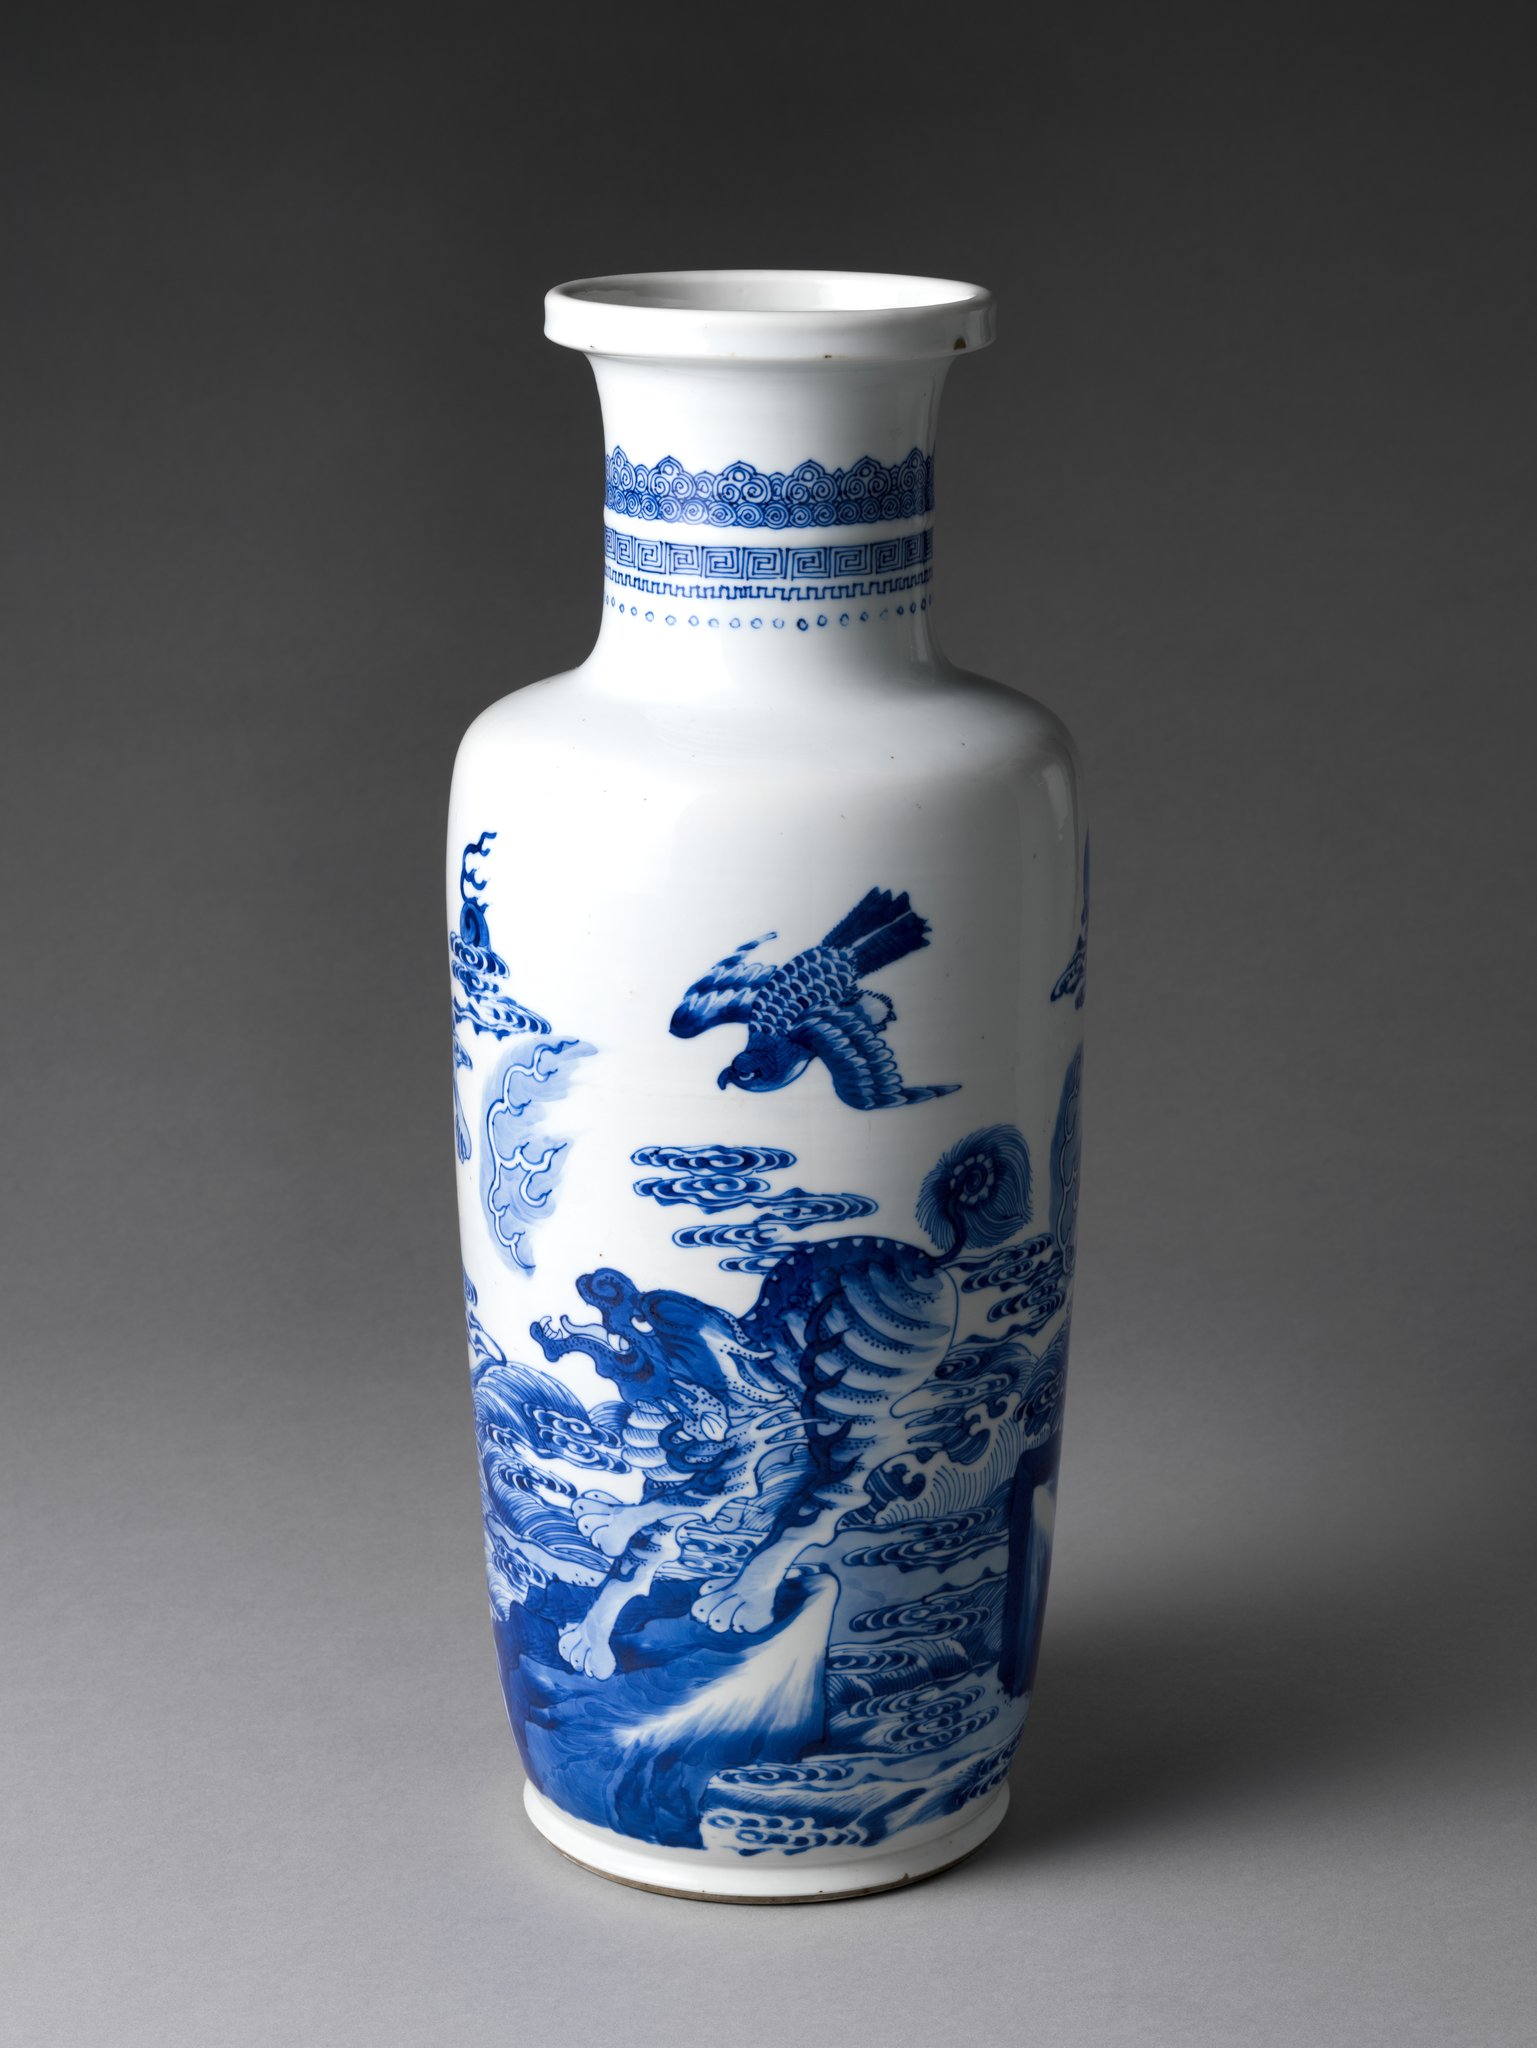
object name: vase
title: Vase with Mythical Creature Chasing Pearl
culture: chinese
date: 1701-1733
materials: cobalt, glaze, porcelain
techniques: painting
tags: birds,mythical creatures